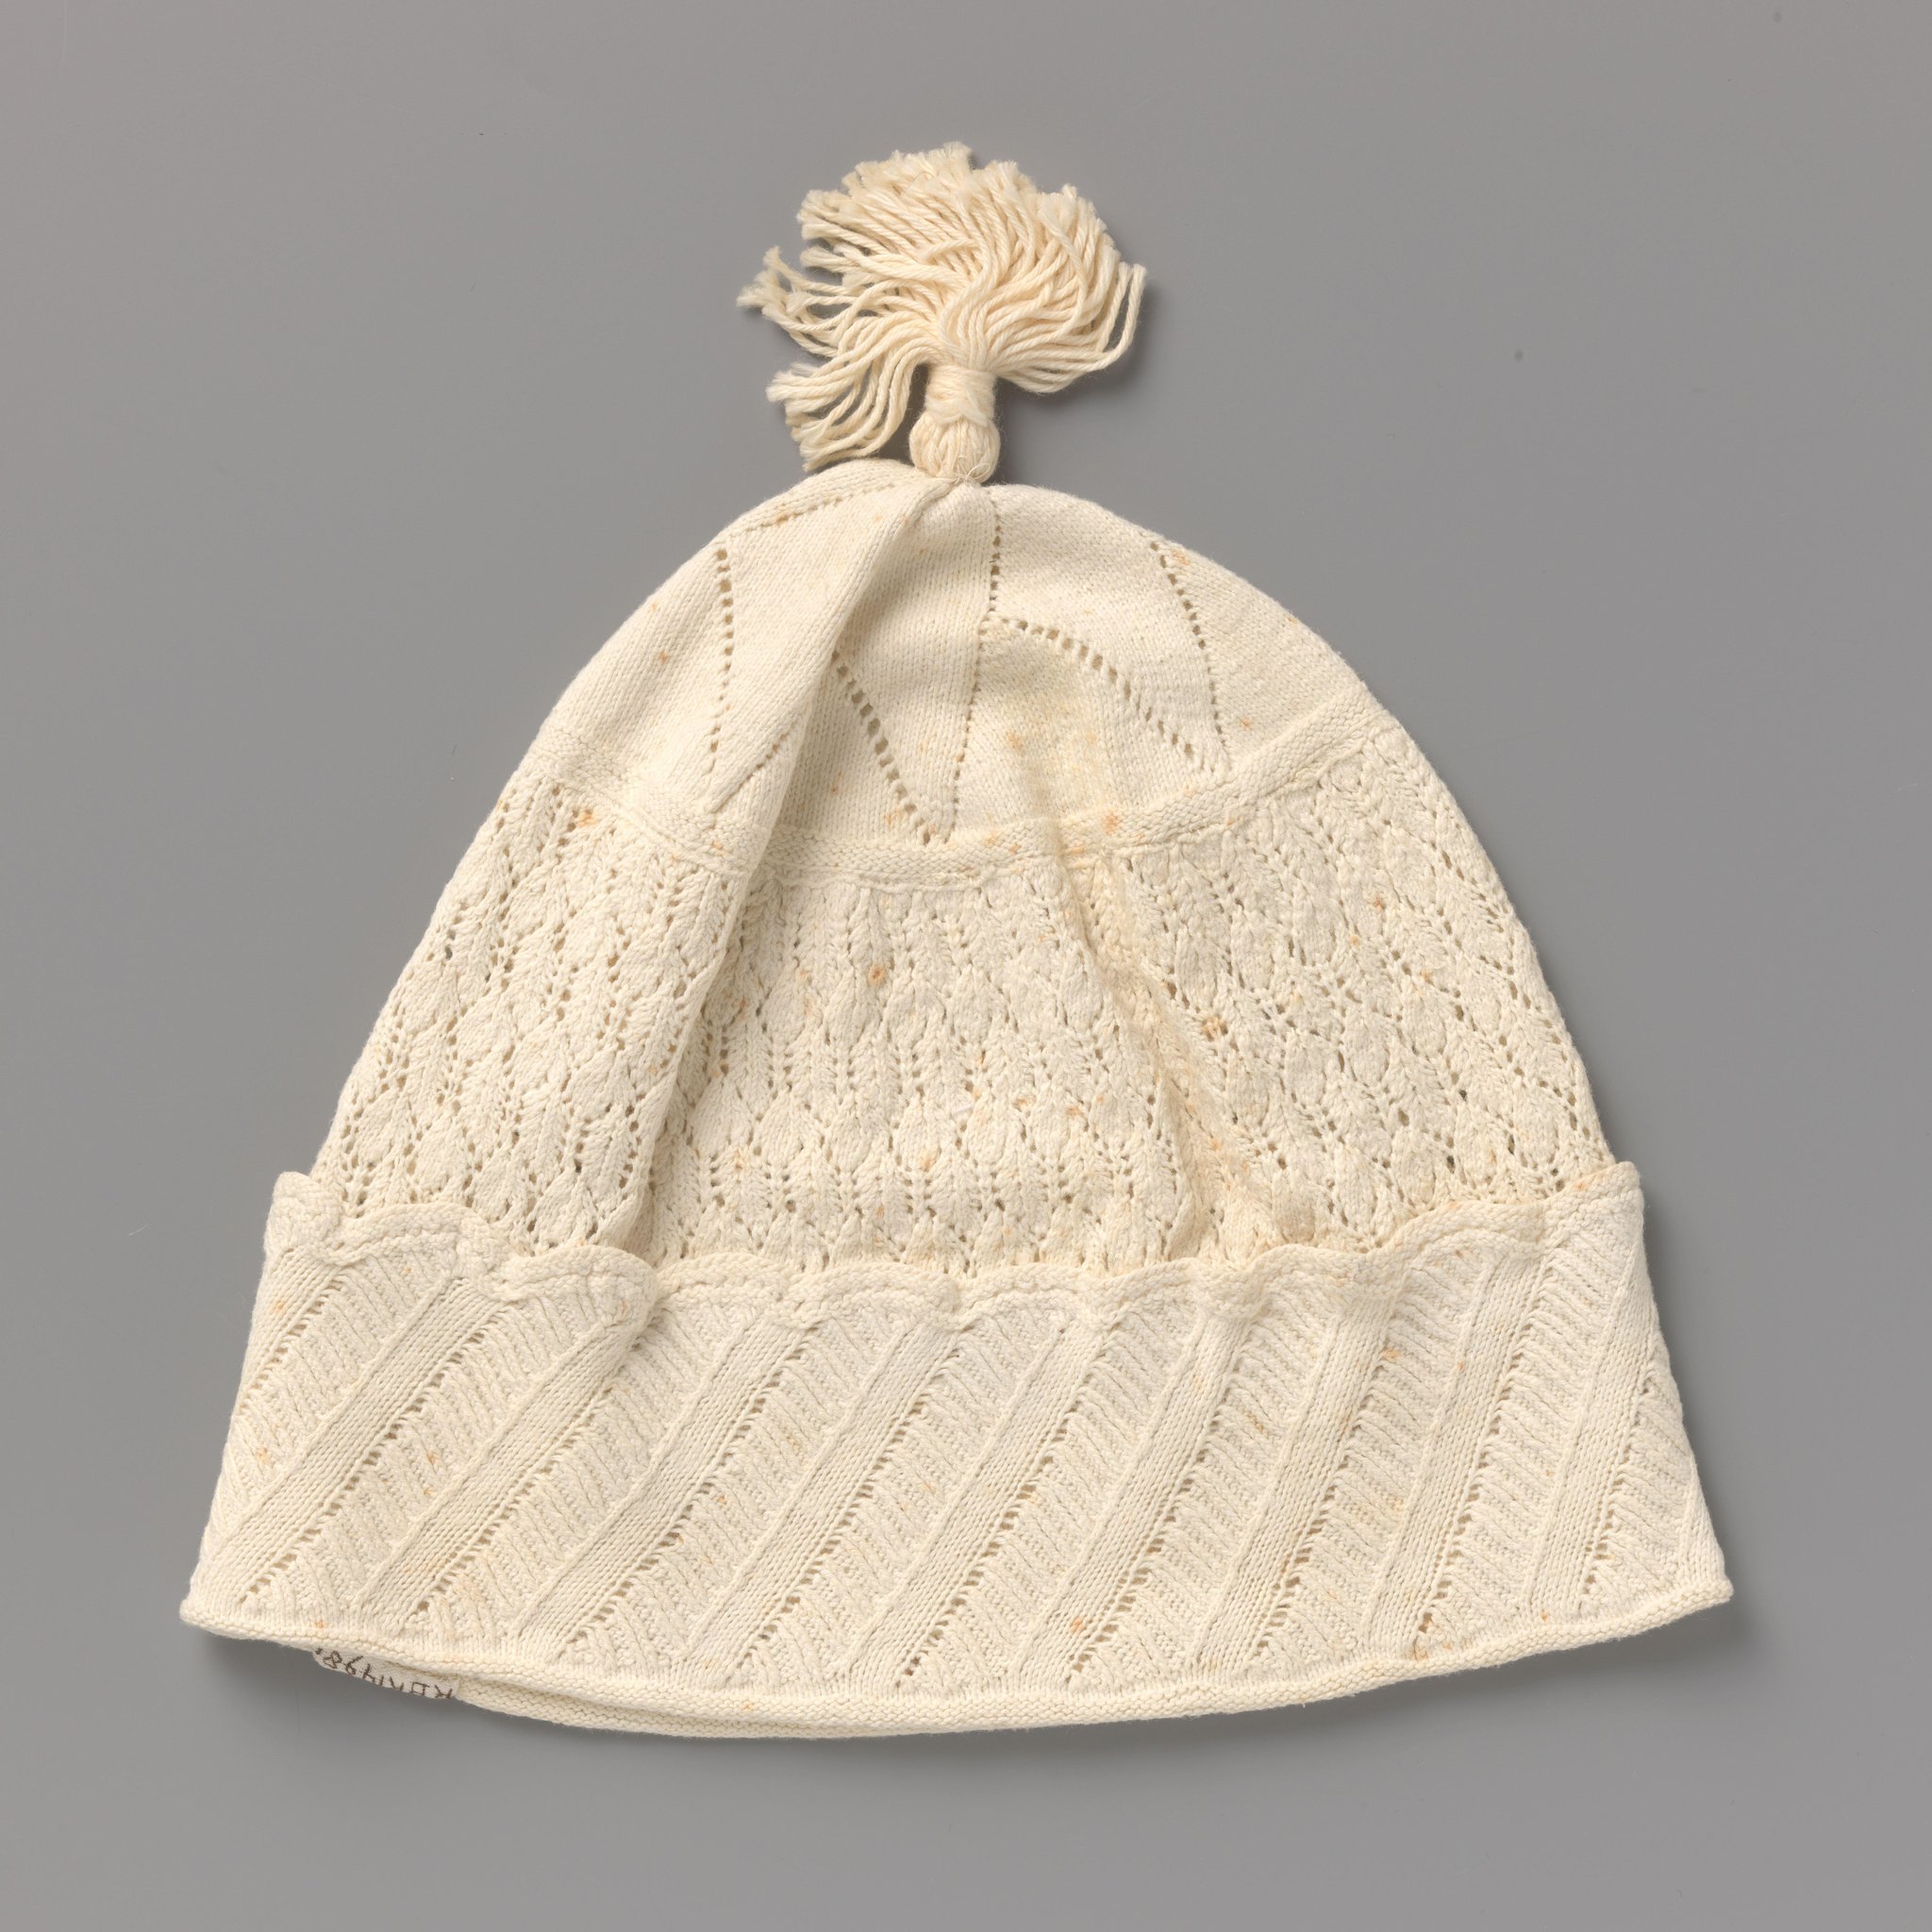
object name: hoofddeksel, hoofdbedekking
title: Gebreide slaapmuts van wit katoen met een omgeslagen geschulpte rand met diagonaal gebreide strepen, waarboven een sierpatroon; bovenop stervorm met ajourranden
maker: Anonymous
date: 1800-1850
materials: cotton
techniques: embroidery, knitting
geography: netherlands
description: Gebreide slaapmuts van uit katoen. Een omgeslagen geschulpte rand met diagonaal gebreide strepen. De bol is eerst recht gebreid, waarop volgt een rand van bladvormen, terwijl de kruin in driehoeken à jour omrand, gebreid zijn. Het kwastje is later toegevoegd.